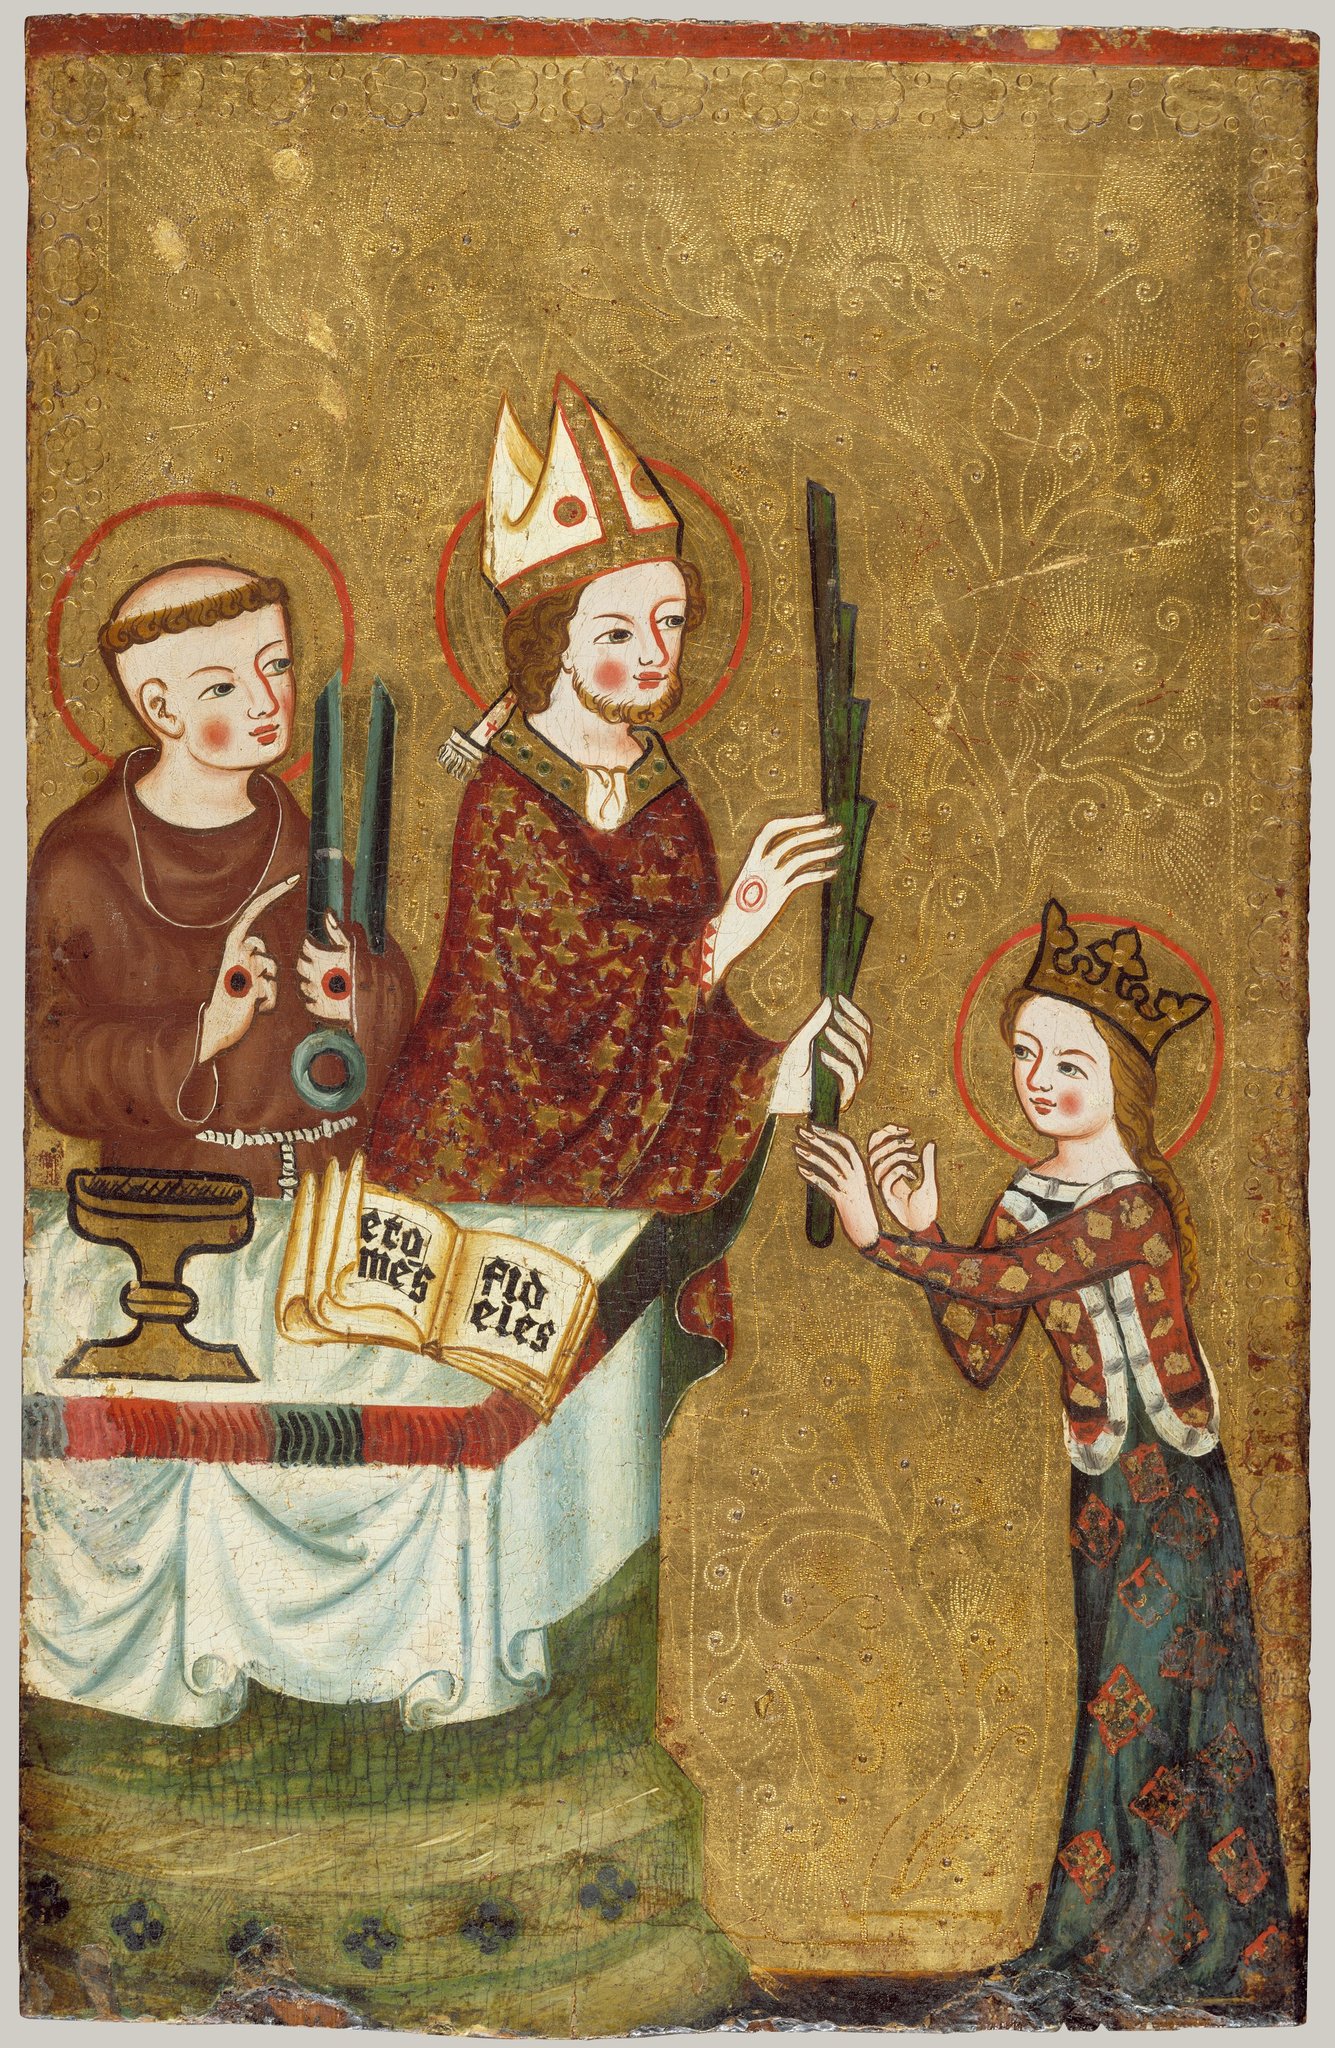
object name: painting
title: The Bishop of Assisi Giving a Palm to Saint Clare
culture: german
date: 1360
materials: gold, oil, silver, wood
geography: germany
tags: men,women,palms,bishops,saints